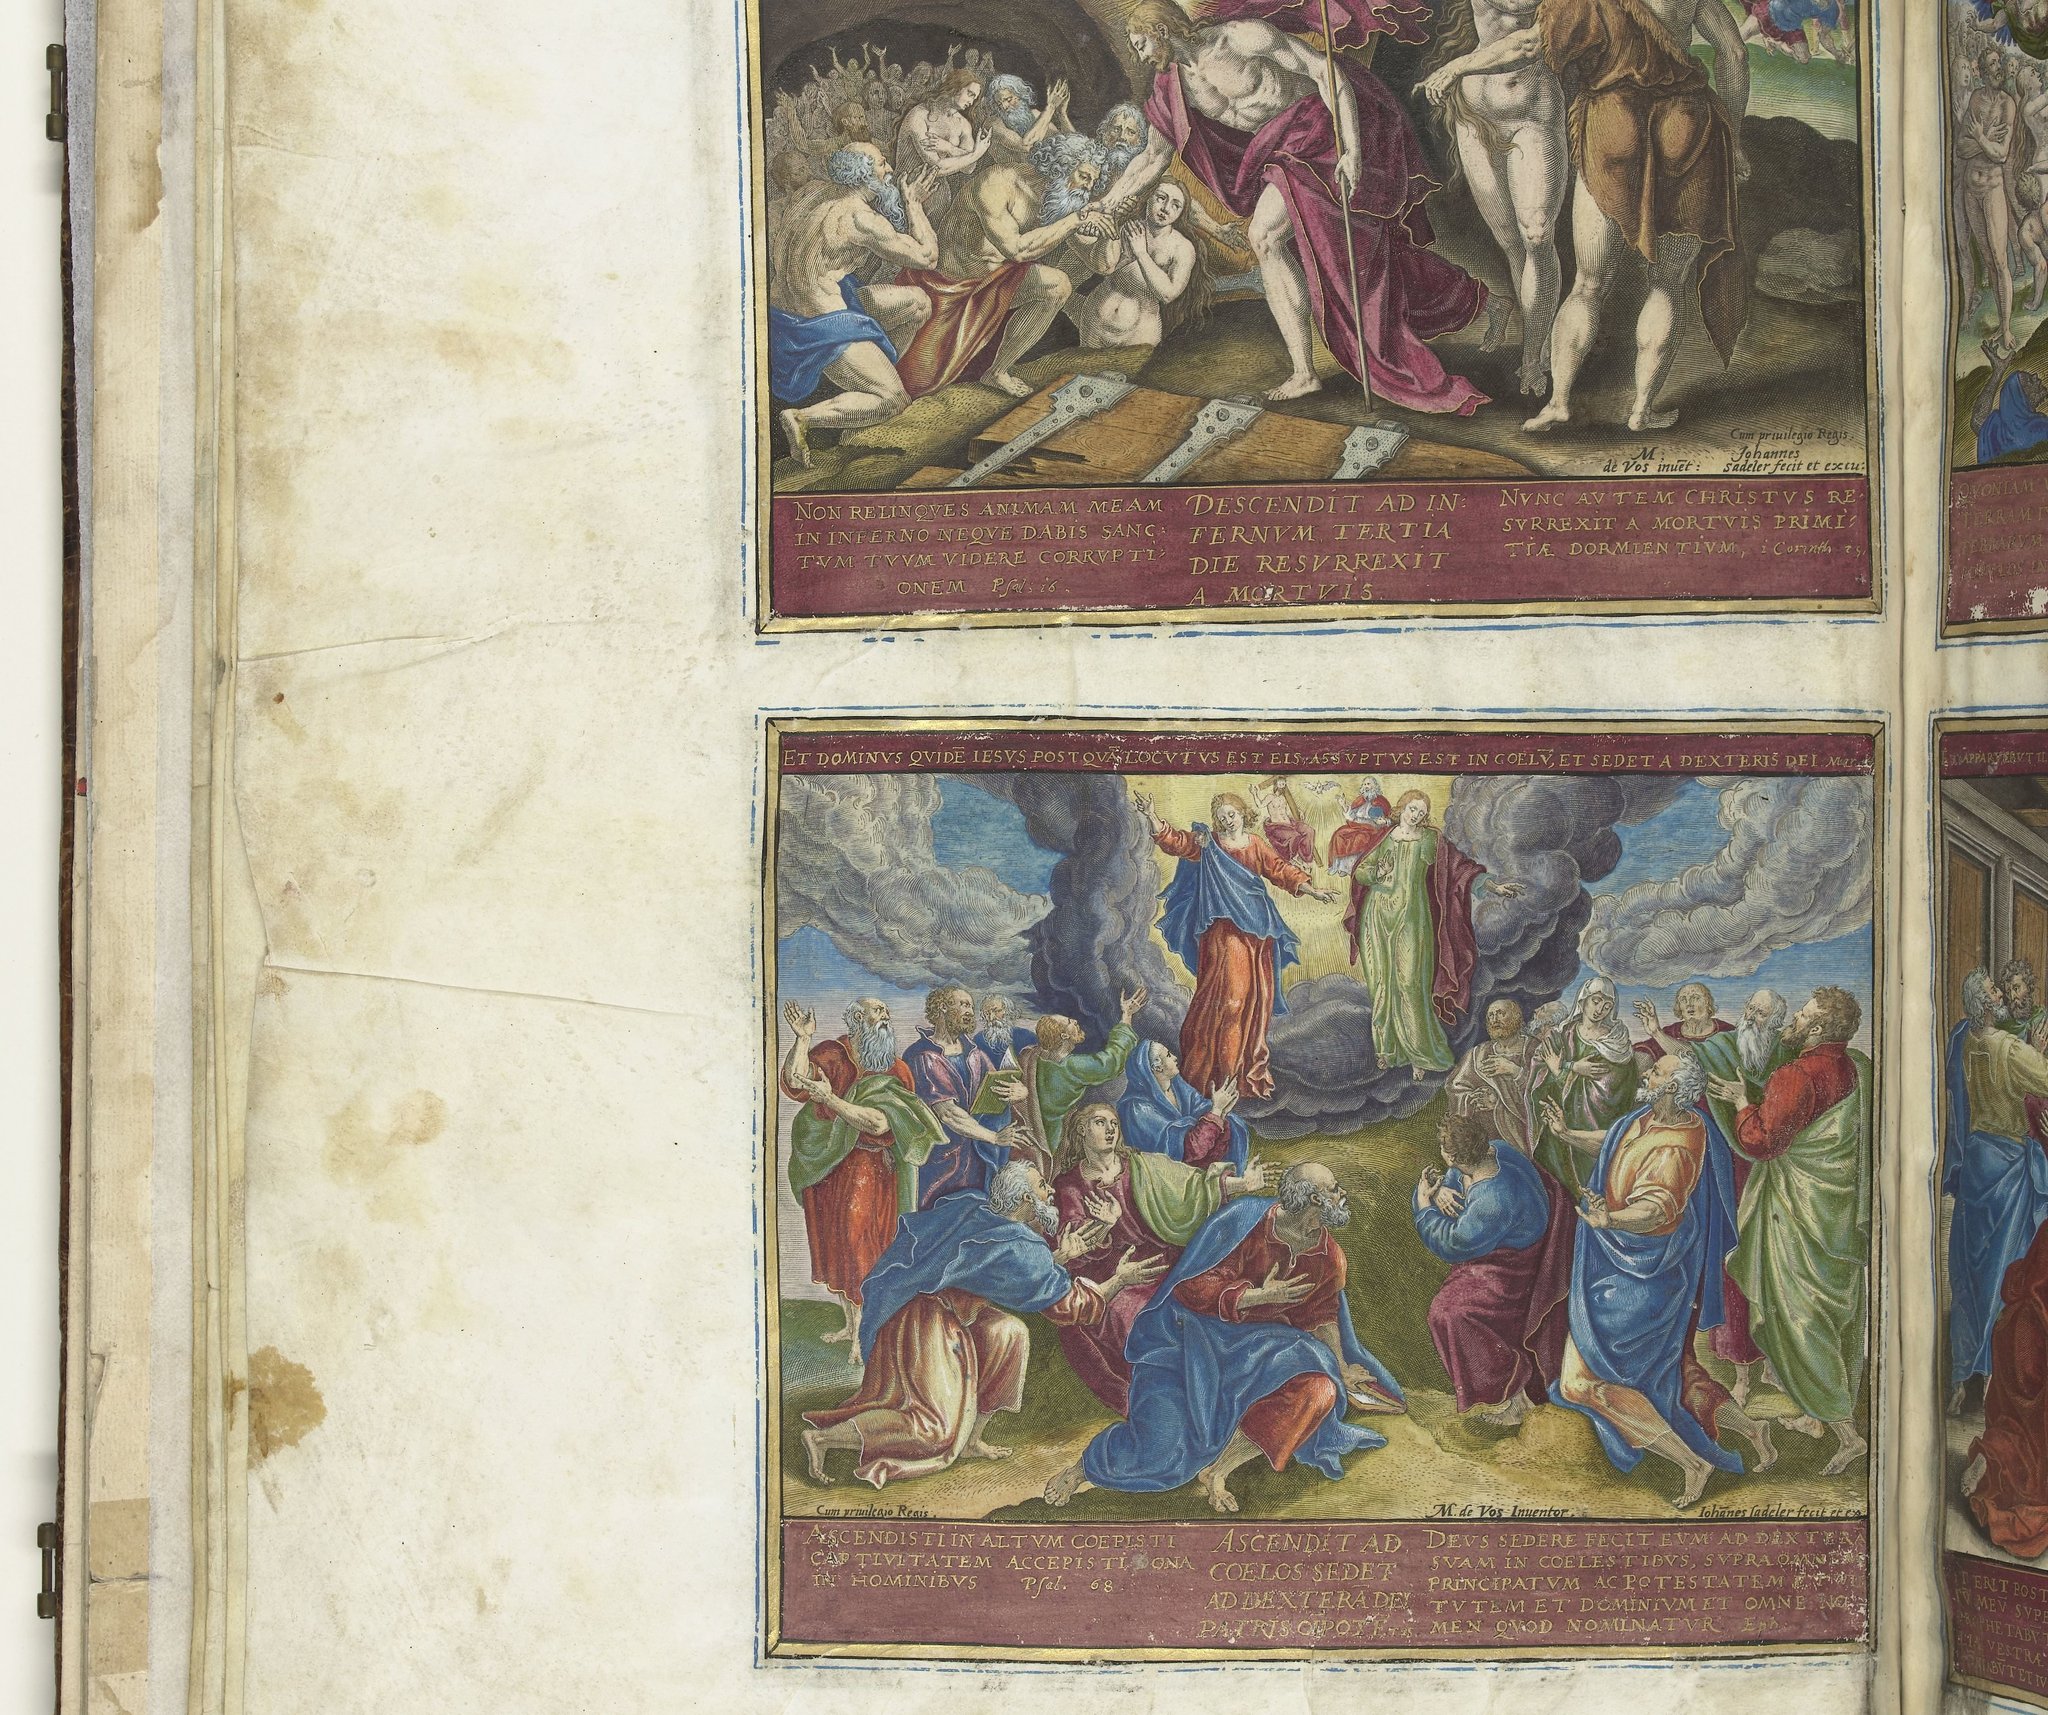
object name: album leaf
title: Descendit ad infernum tertia die resurrexit a mortuis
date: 1579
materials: paper, parchment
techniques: engraving, hand coloring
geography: cologne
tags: christ in the underworld, harrowing of hell, christ in limbo, 'descensus ad inferos', 'anastasis', 'descendit ad inferna, tertia die resurrexit a mortuis' ~ articles of faith, christ, usually holding a banner, arises from the grave; often combined with sleeping and/or frightened soldiers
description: Illustratie van het vijfde geloofsartikel ([Christus] die nedergedaald is ter helle; de derde dag verrezen uit de doden) van de apostolische geloofsbelijdenis. Christus daalt na zijn dood af naar het voorgeborchte. Hij heeft de poorten van de hel gebroken en reikt de hand aan oudtestamentische heiligen. Naast hem staan Adam en Eva. Op de achtergrond rechts de opstanding van Christus. Boven de voorstelling een verwijzing naar de Bijbeltekst in Mat. 12:40. Onder de voorstelling twee Bijbelteksten en het vijfde geloofsartikel uit de apostolische geloofsbelijdenis in het Latijn. Deze prent maakt deel uit van een album.